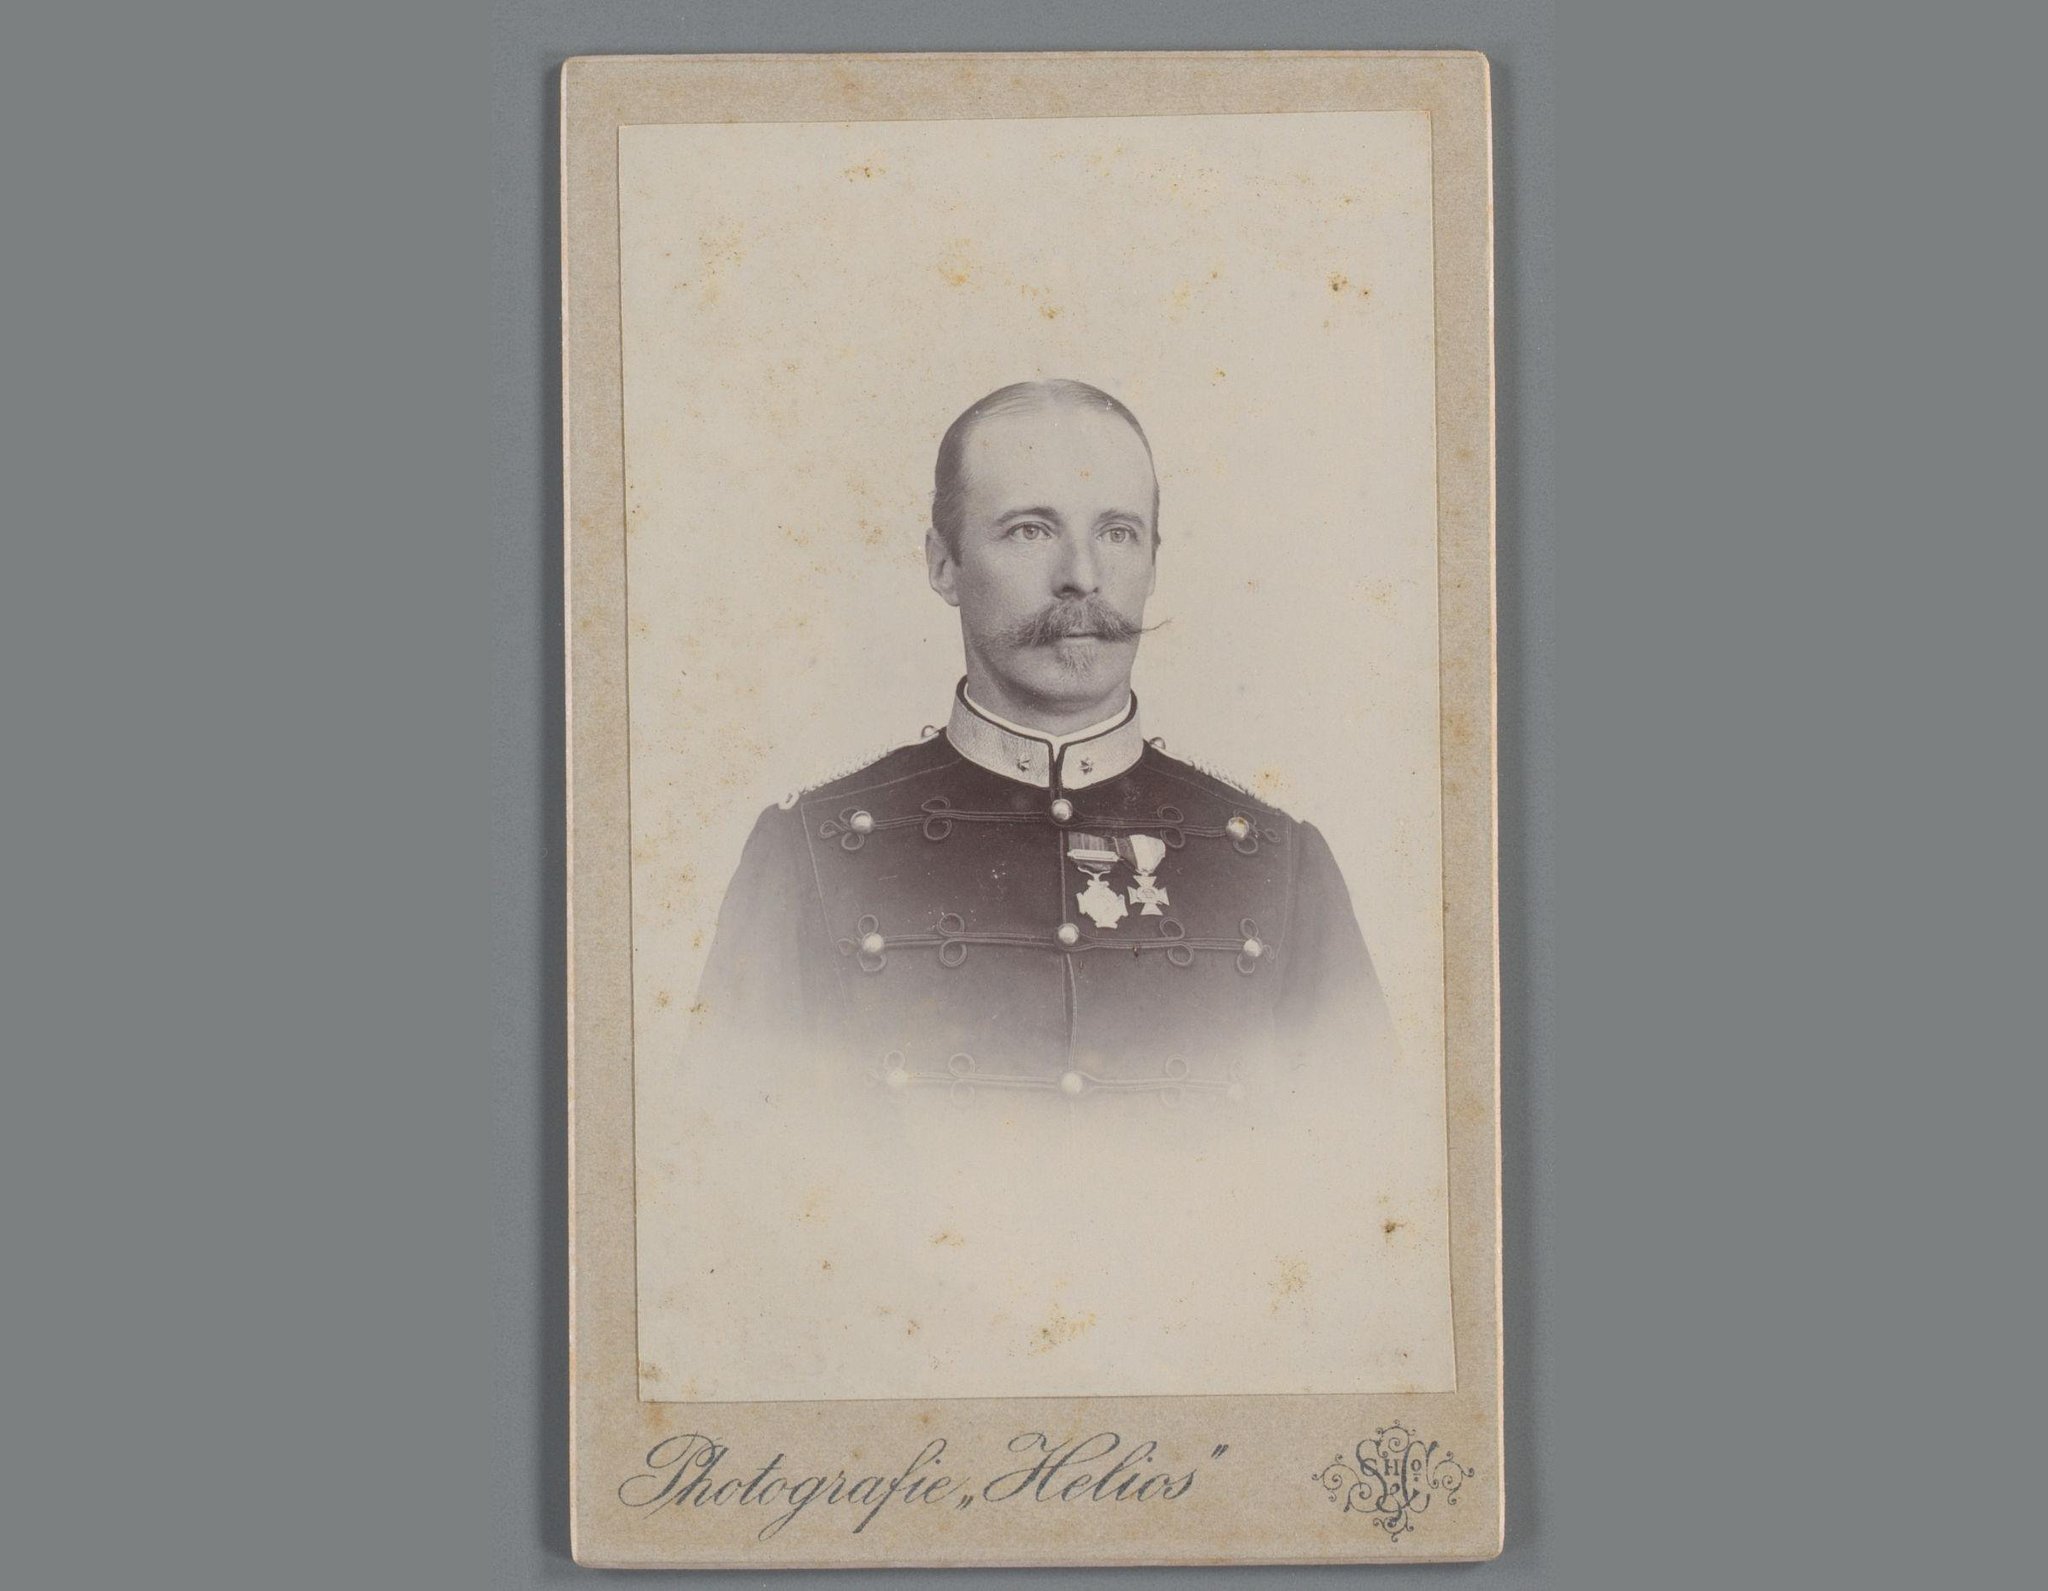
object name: carte de visite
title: Portret van een onbekende man in militair uniform, mogelijk een lid van de familie Onnen-van den Berg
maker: r. schütz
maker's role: fotograaf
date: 1885-1914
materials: paper, cardboard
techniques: collodion silver print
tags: anonymous historical person portrayed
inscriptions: inscription: ‘Photografisch Atelier/ "Helios"/ Schütz en Co.’